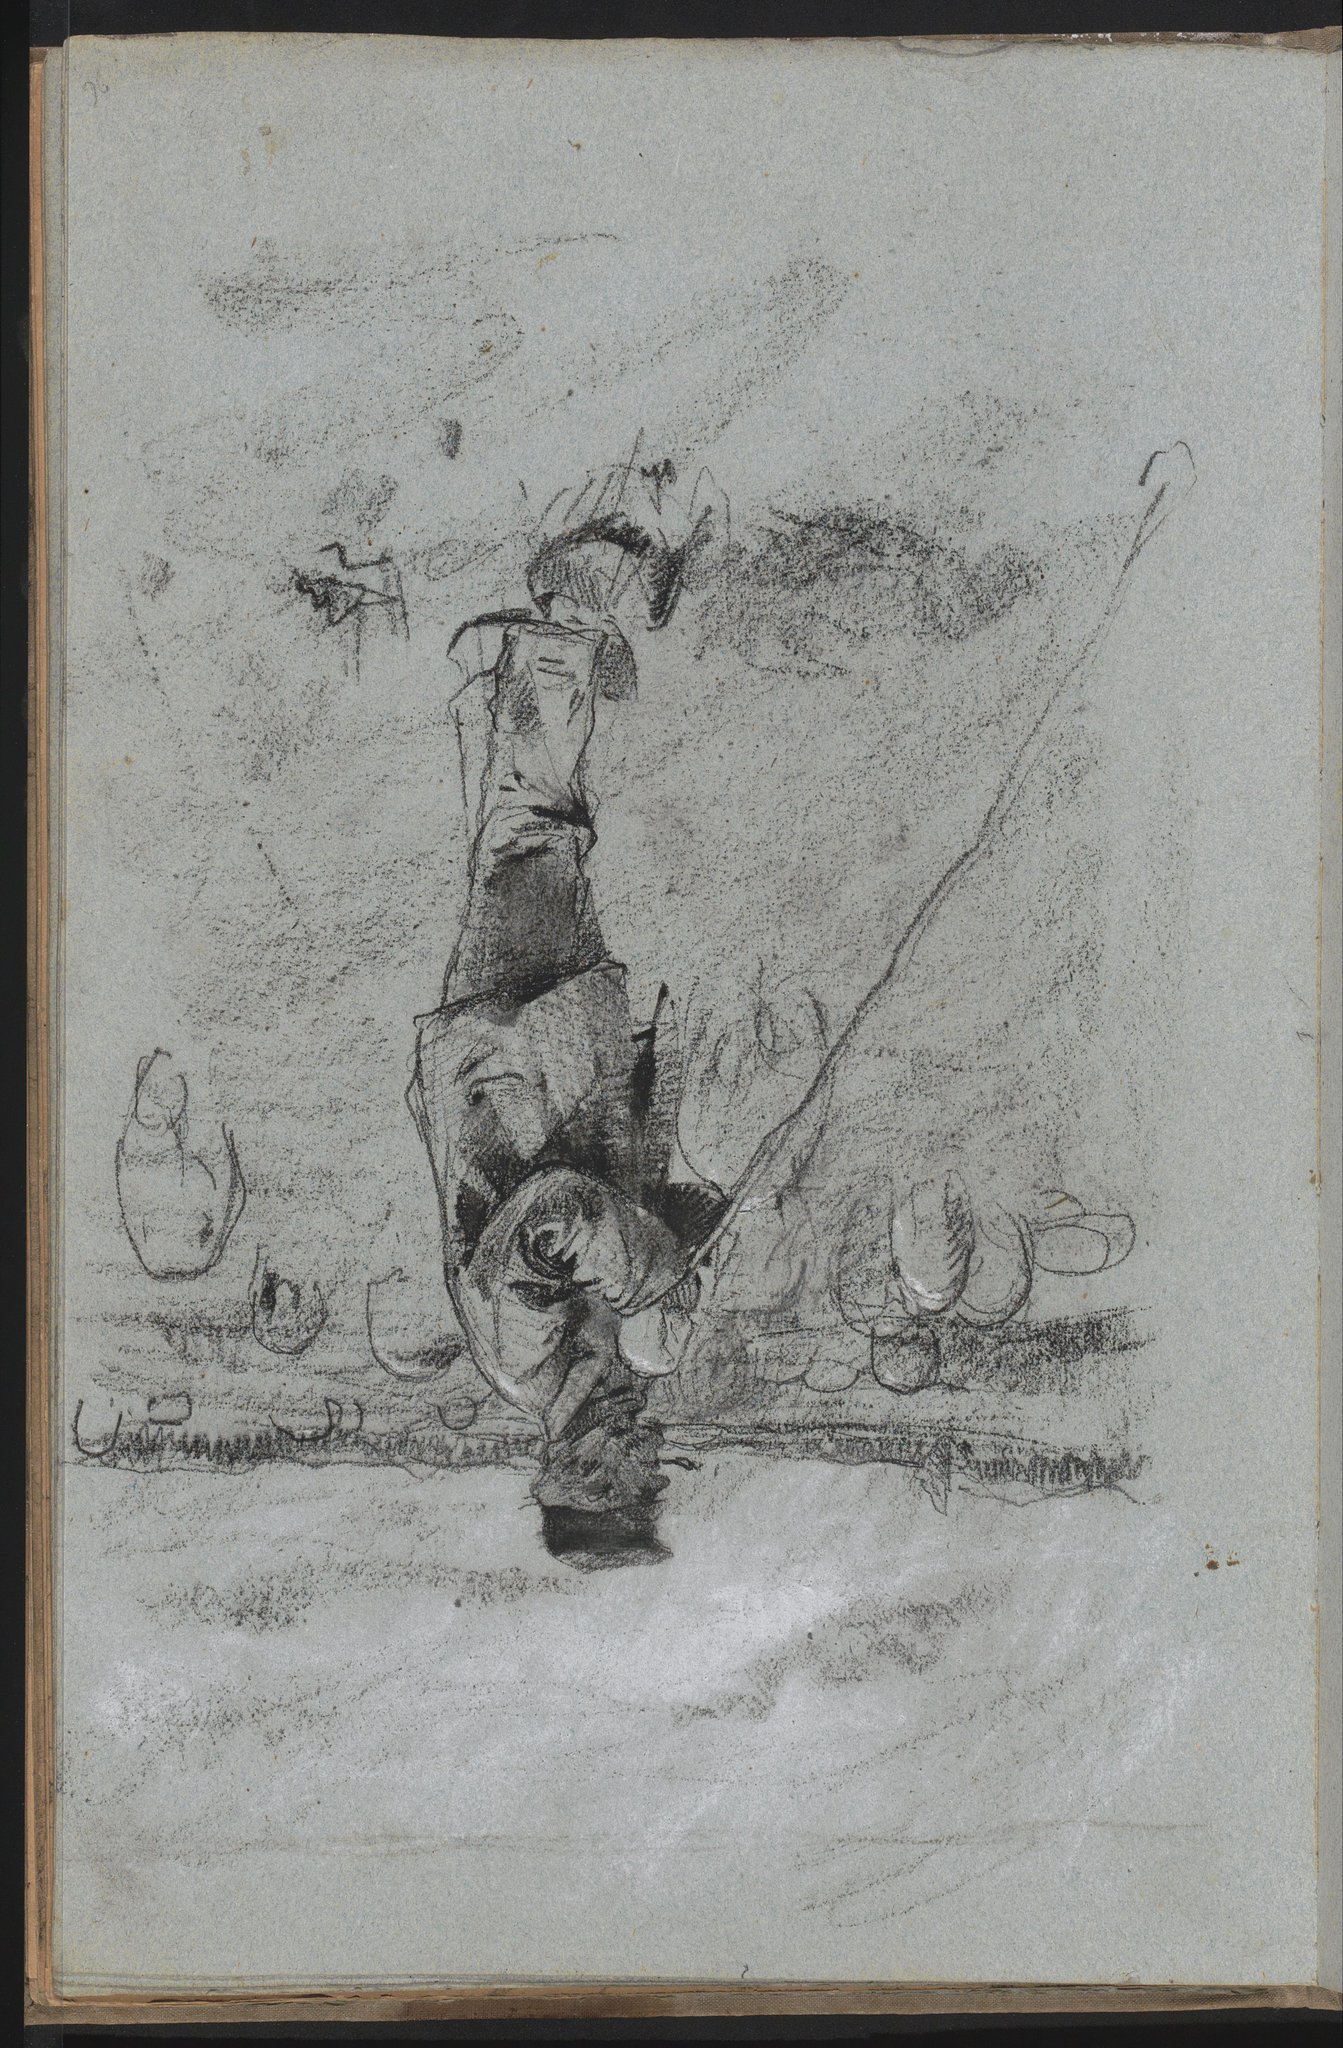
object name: sketchbook leaf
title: Landschap met een schaapherder die op zijn staf leunt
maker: willem witsen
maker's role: draughtsman, painter, print maker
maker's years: 1860-1923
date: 1884-1887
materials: chalk, paper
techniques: stumping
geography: ewijkshoeve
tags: landscapes in the temperate zone, cattle driving, cattle driver, sheep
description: Voorstudie voor de ets 'Staande schaapherder, leunend op zijn staf, kijkend naar rechts, ca. 1886-1906.